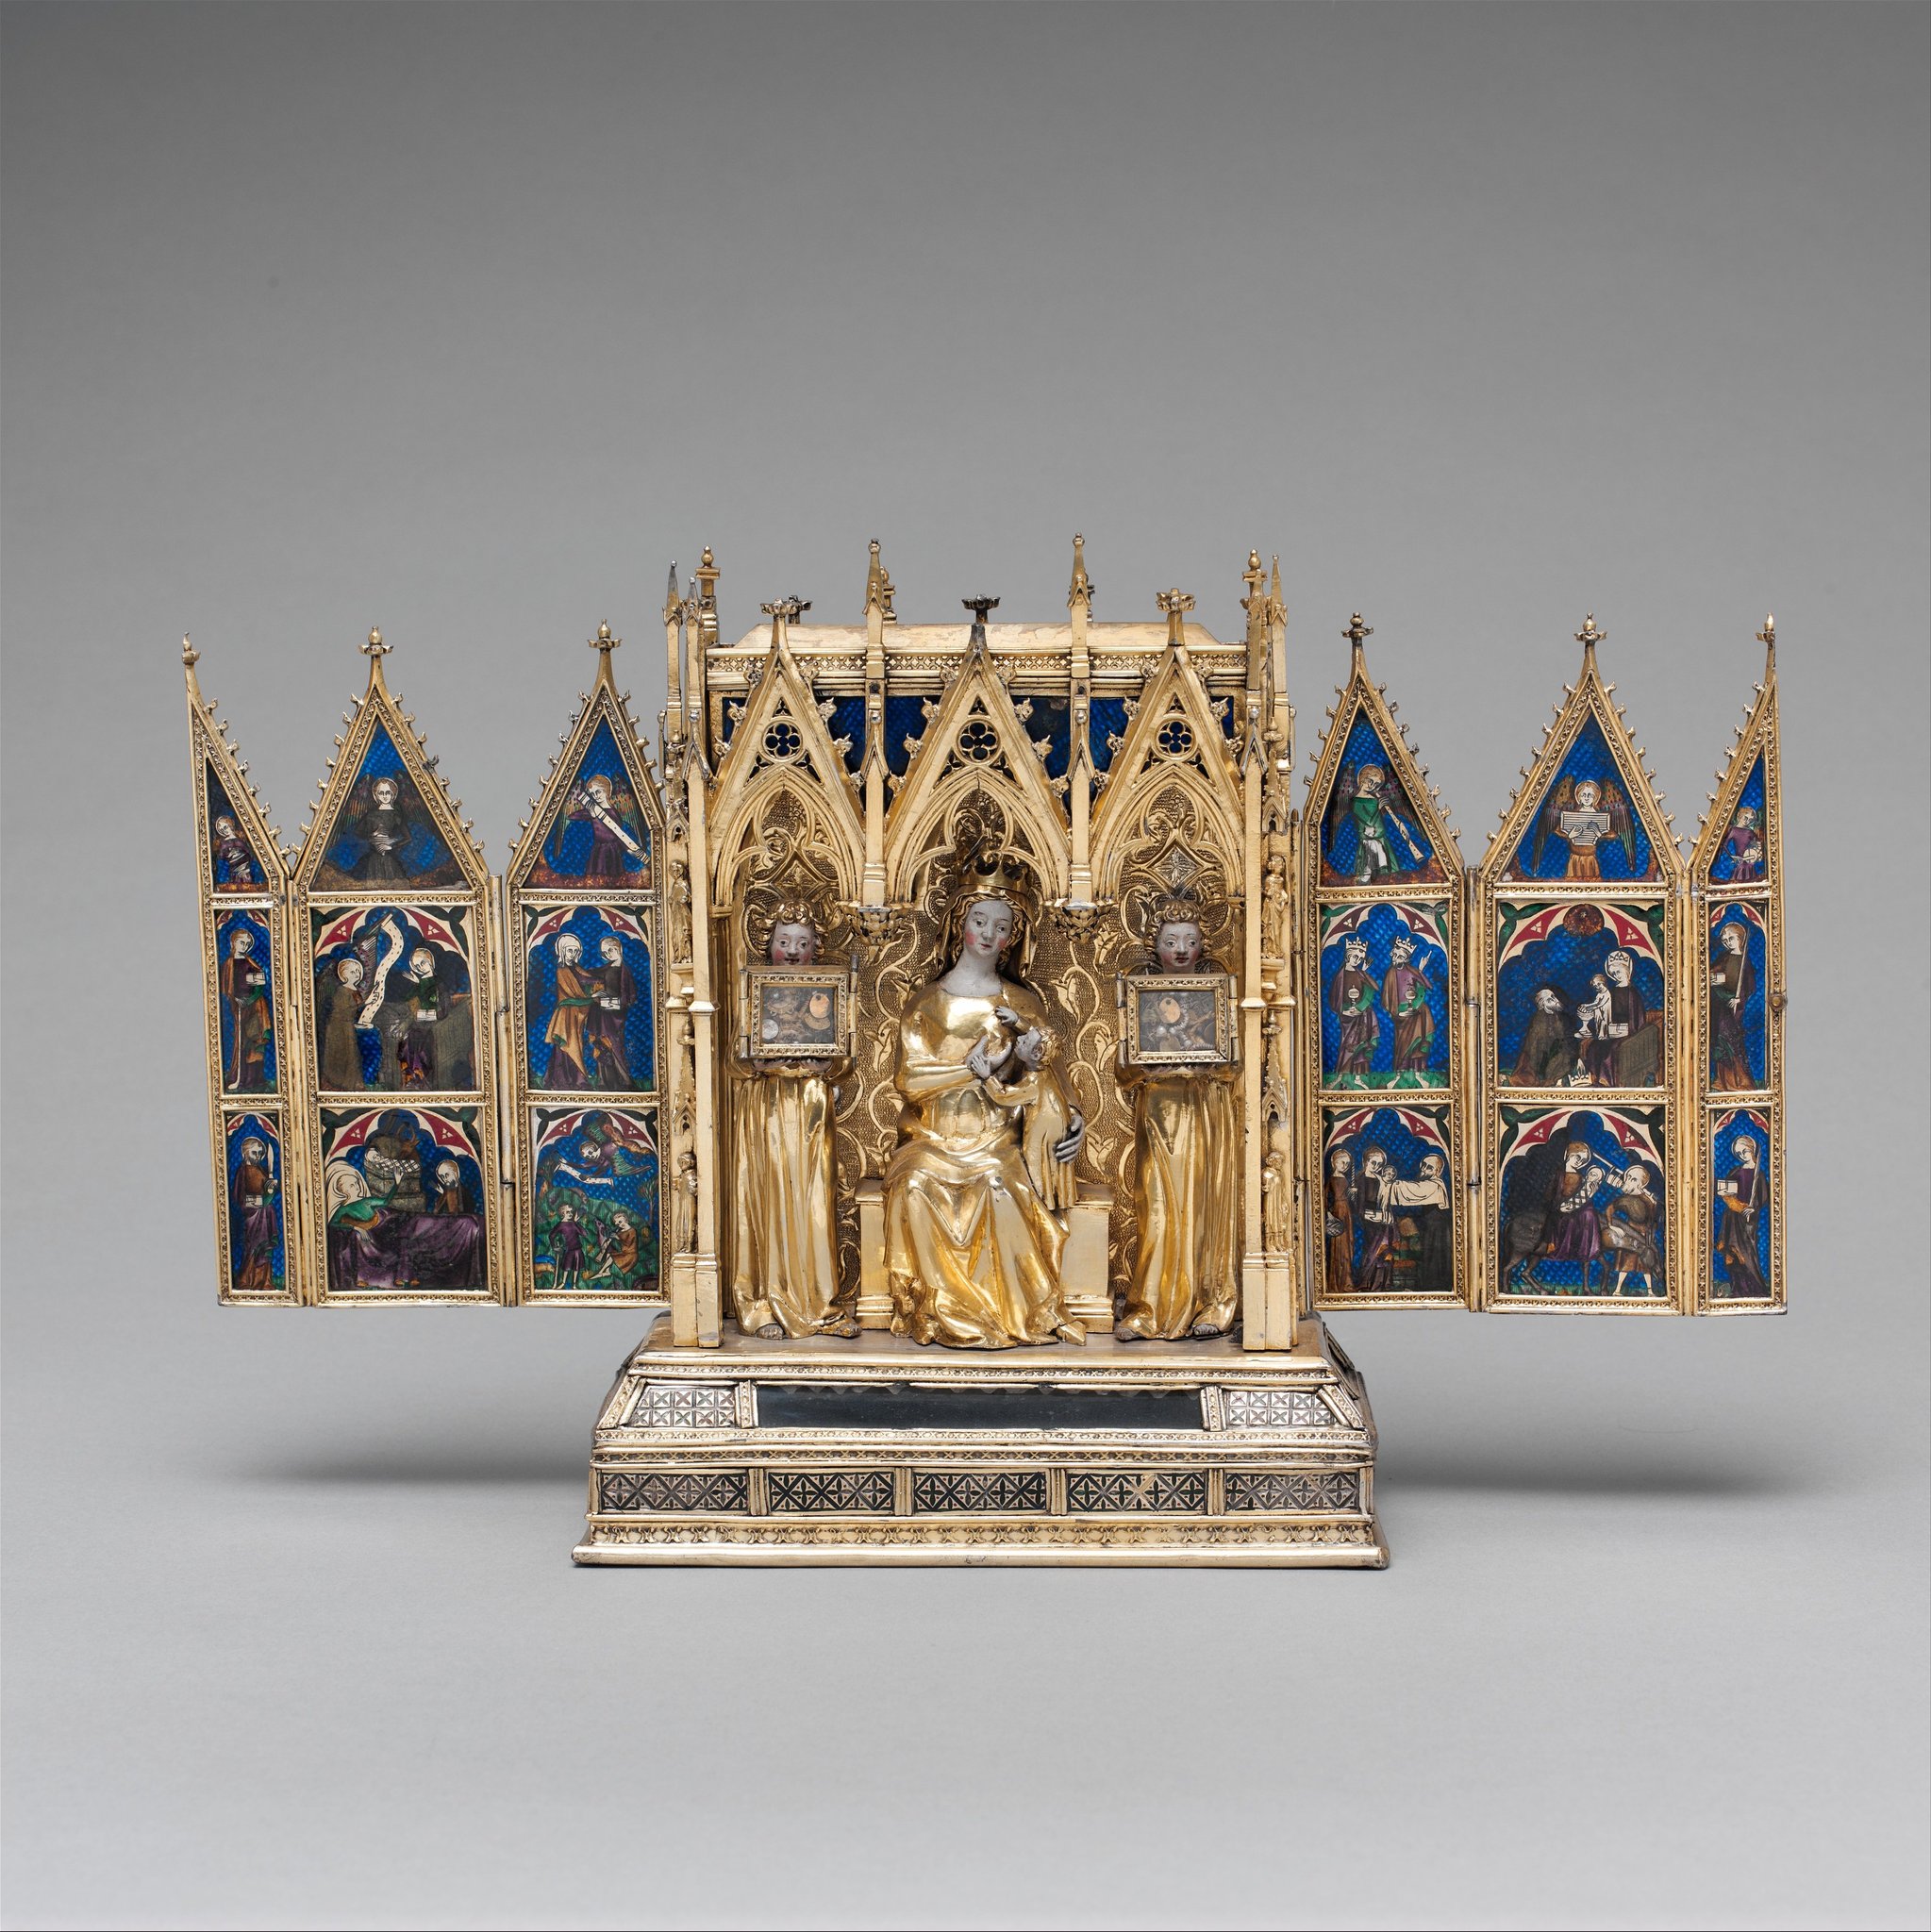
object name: reliquary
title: Reliquary Shrine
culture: french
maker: jean de touyl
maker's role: artist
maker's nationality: french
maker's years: 1270-1350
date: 1325-1350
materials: enamel, gilt silver, paint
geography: france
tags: angels,madonna and child,virgin mary,jesus,nursing